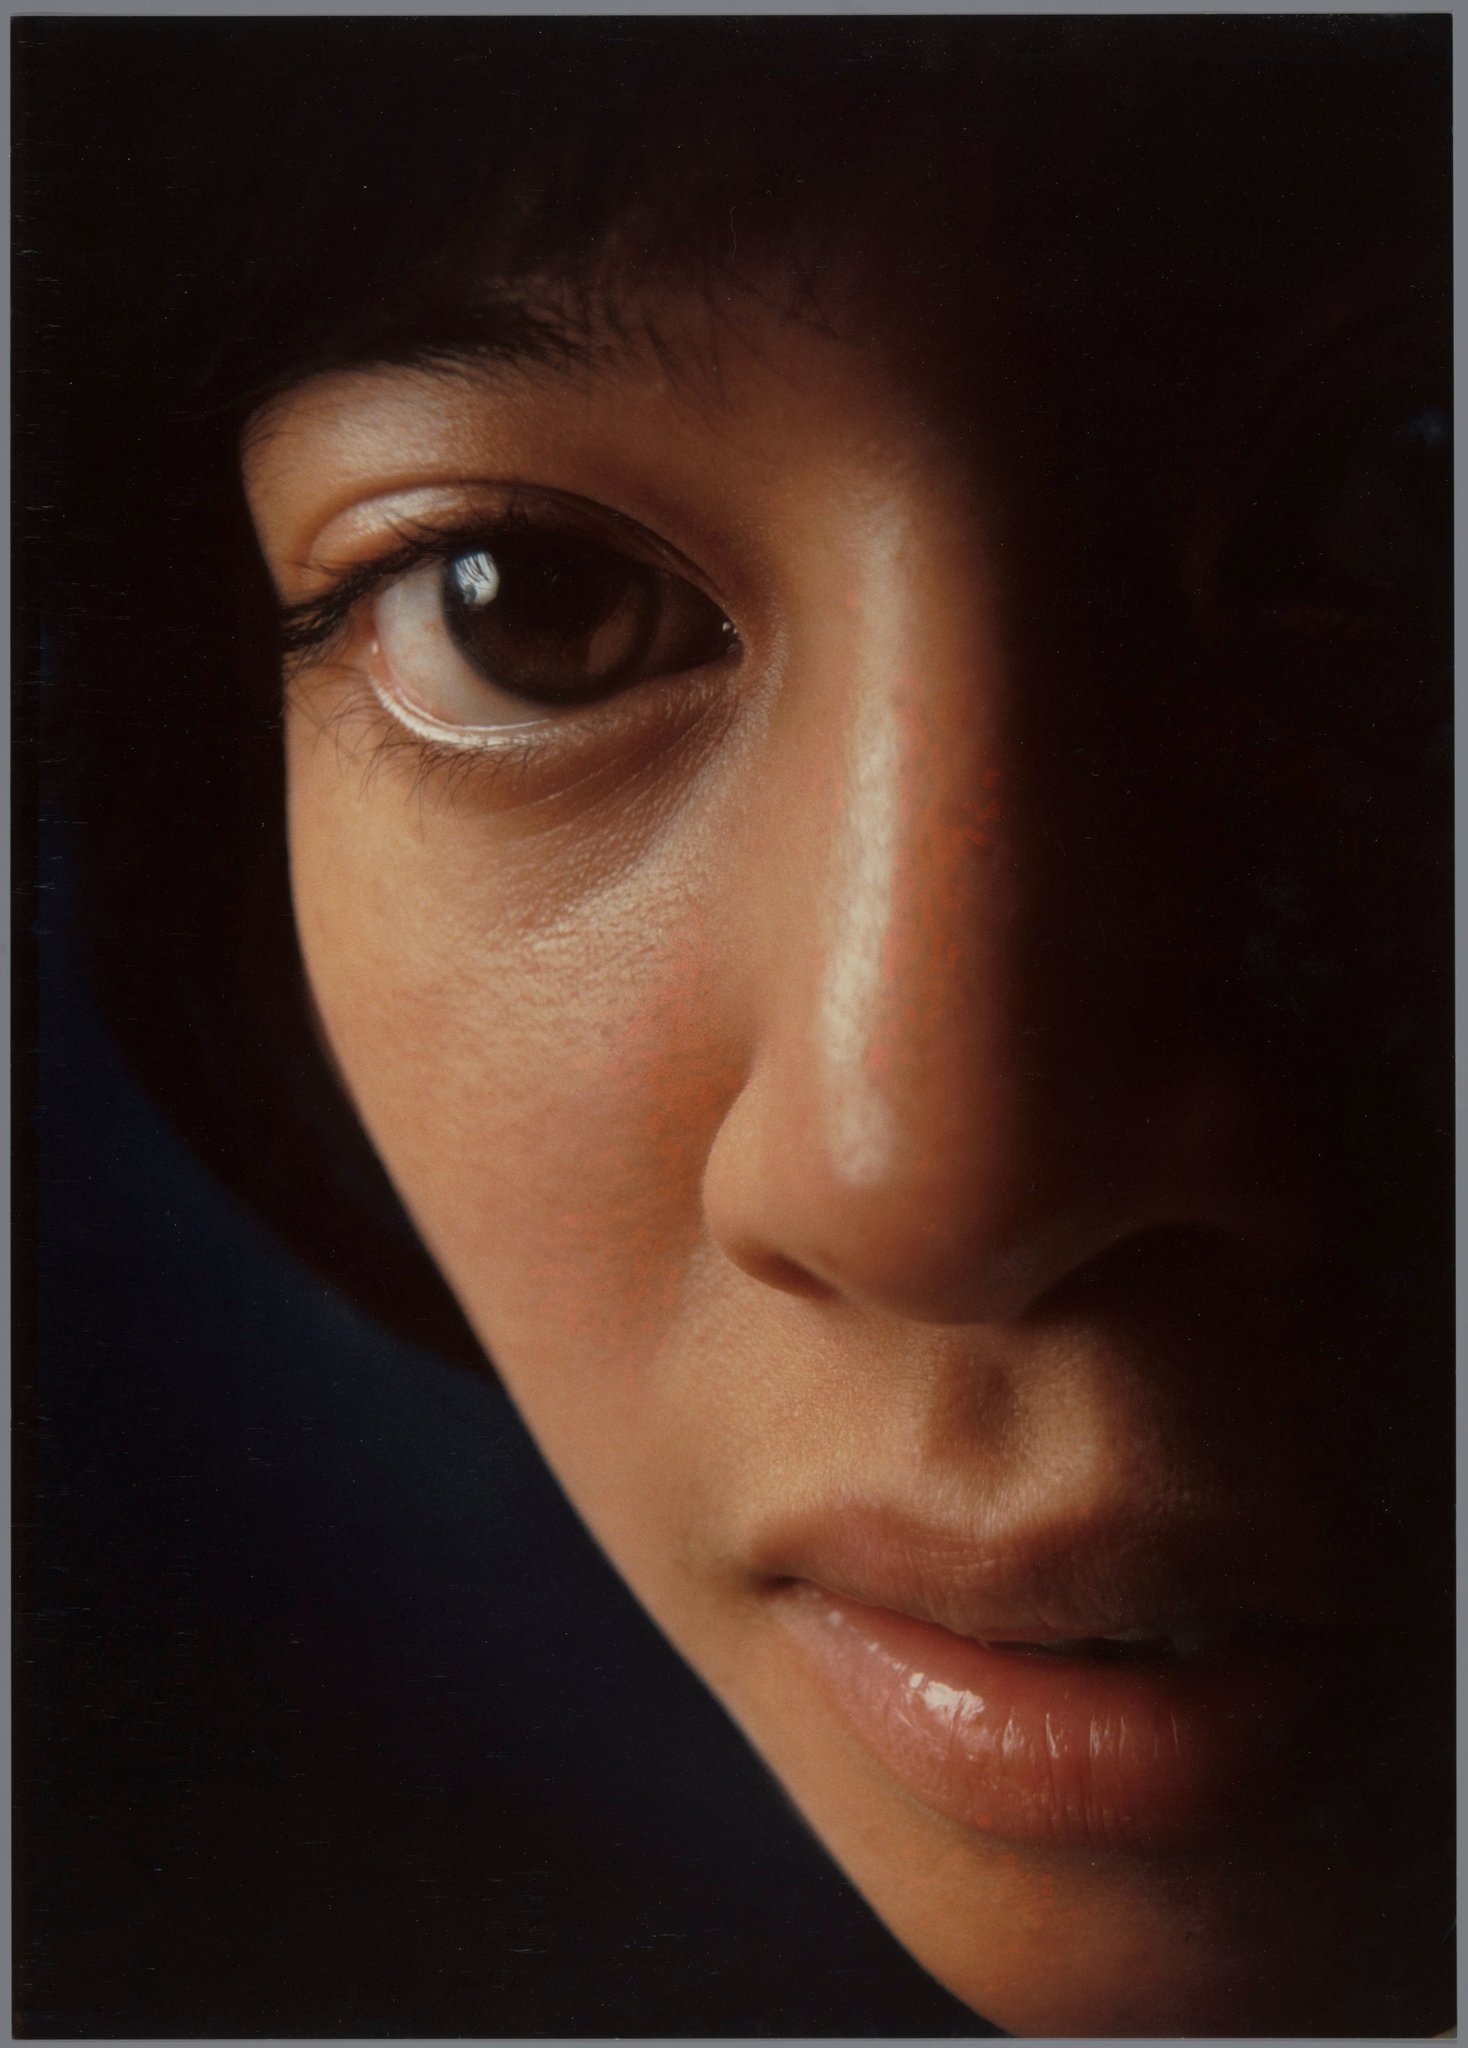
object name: photograph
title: Portret Indische vrouw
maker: theo germann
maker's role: draughtsman, sculptor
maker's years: 1926-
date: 1965-1994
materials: photographic support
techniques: chromogenic print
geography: utrecht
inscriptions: inscription: ‘Foto abstede c.v. M. Germann. Geachte heer Hartkamp, hierbij stuur ik u .... Ik hoop van harte dat u er veel plezier aan zult beleven. Met hartelijke groeten, hoogachten, M. Germann’